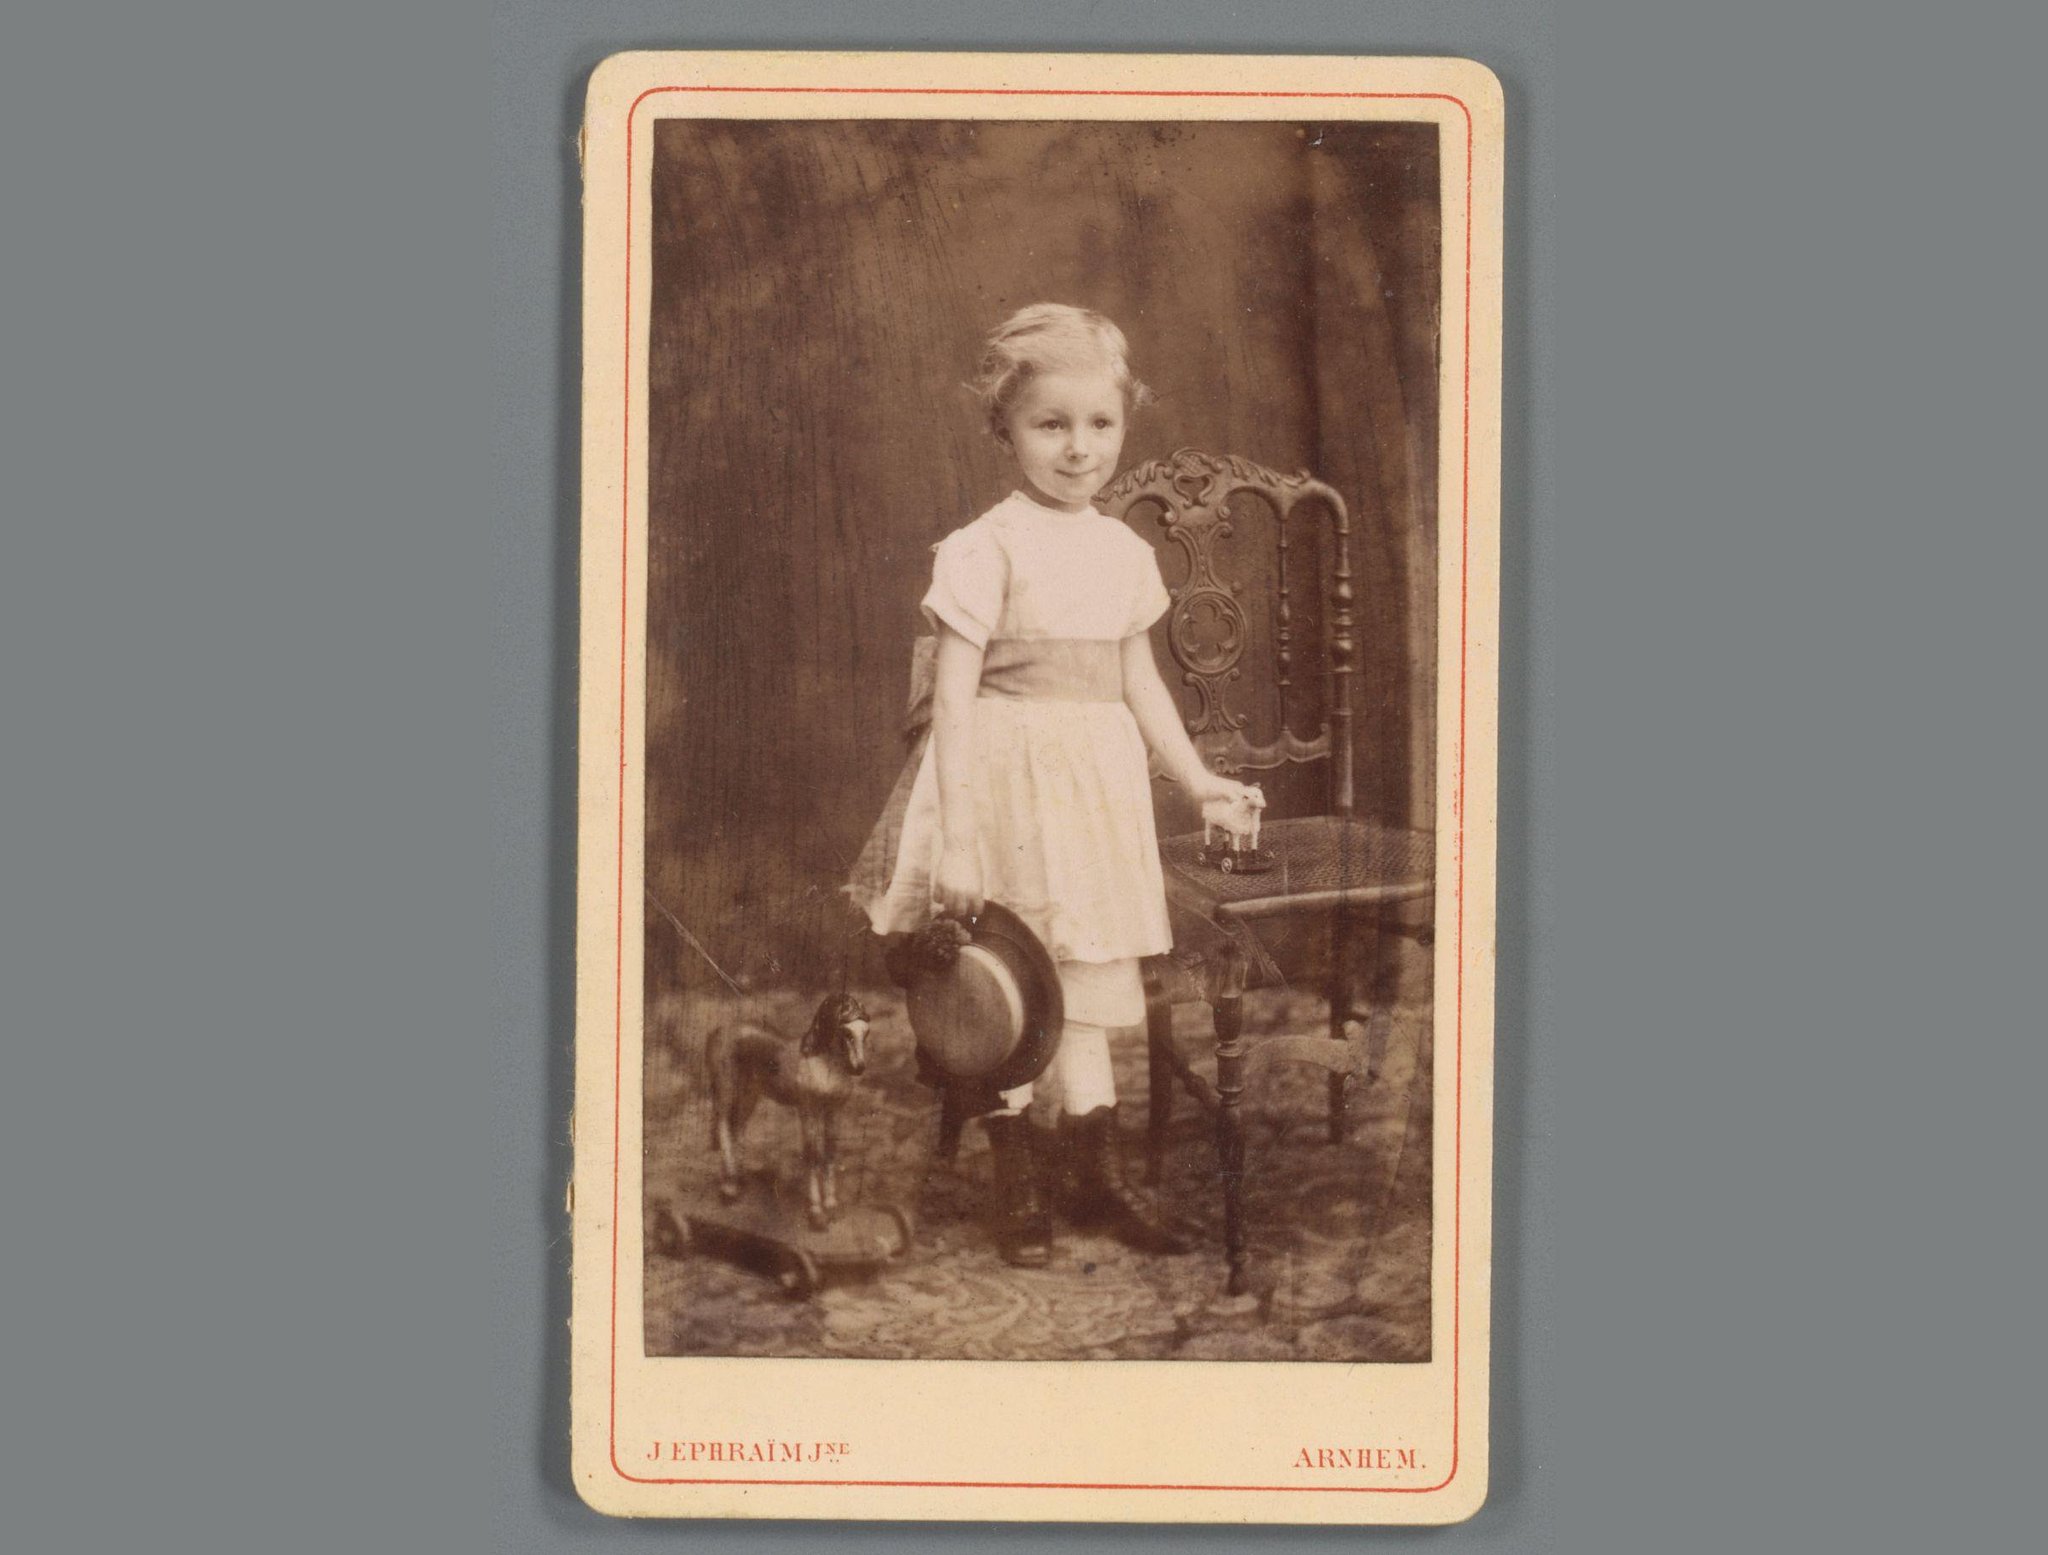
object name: carte de visite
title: Portret van een onbekend meisje met speelgoed uit de familie en de kring van Eugene van Delden en Belle van Delden-Denninghof Stelling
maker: johannes ephraim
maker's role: fotograaf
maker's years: 1838-1921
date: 1866-1878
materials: cardboard, paper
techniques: albumen print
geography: arnhem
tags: (playing with) toy animals, historical persons not known by name - bb - woman, girl (child between toddler and youth)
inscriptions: annotation: ‘Ephraïm Jne/ Specialité d'Agrandaissements/ J. Ephraïm Jne/ Rijnkade 312/ Arnhem/ Les clichés sont conservés.’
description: Portret uit de kring van Eugene van Delden (Hartapoera, 1865 - Den Haag, 1954) en Belle van Delden-Denninghof Stelling (Batavia, 1870 - Den Haag, 1947).